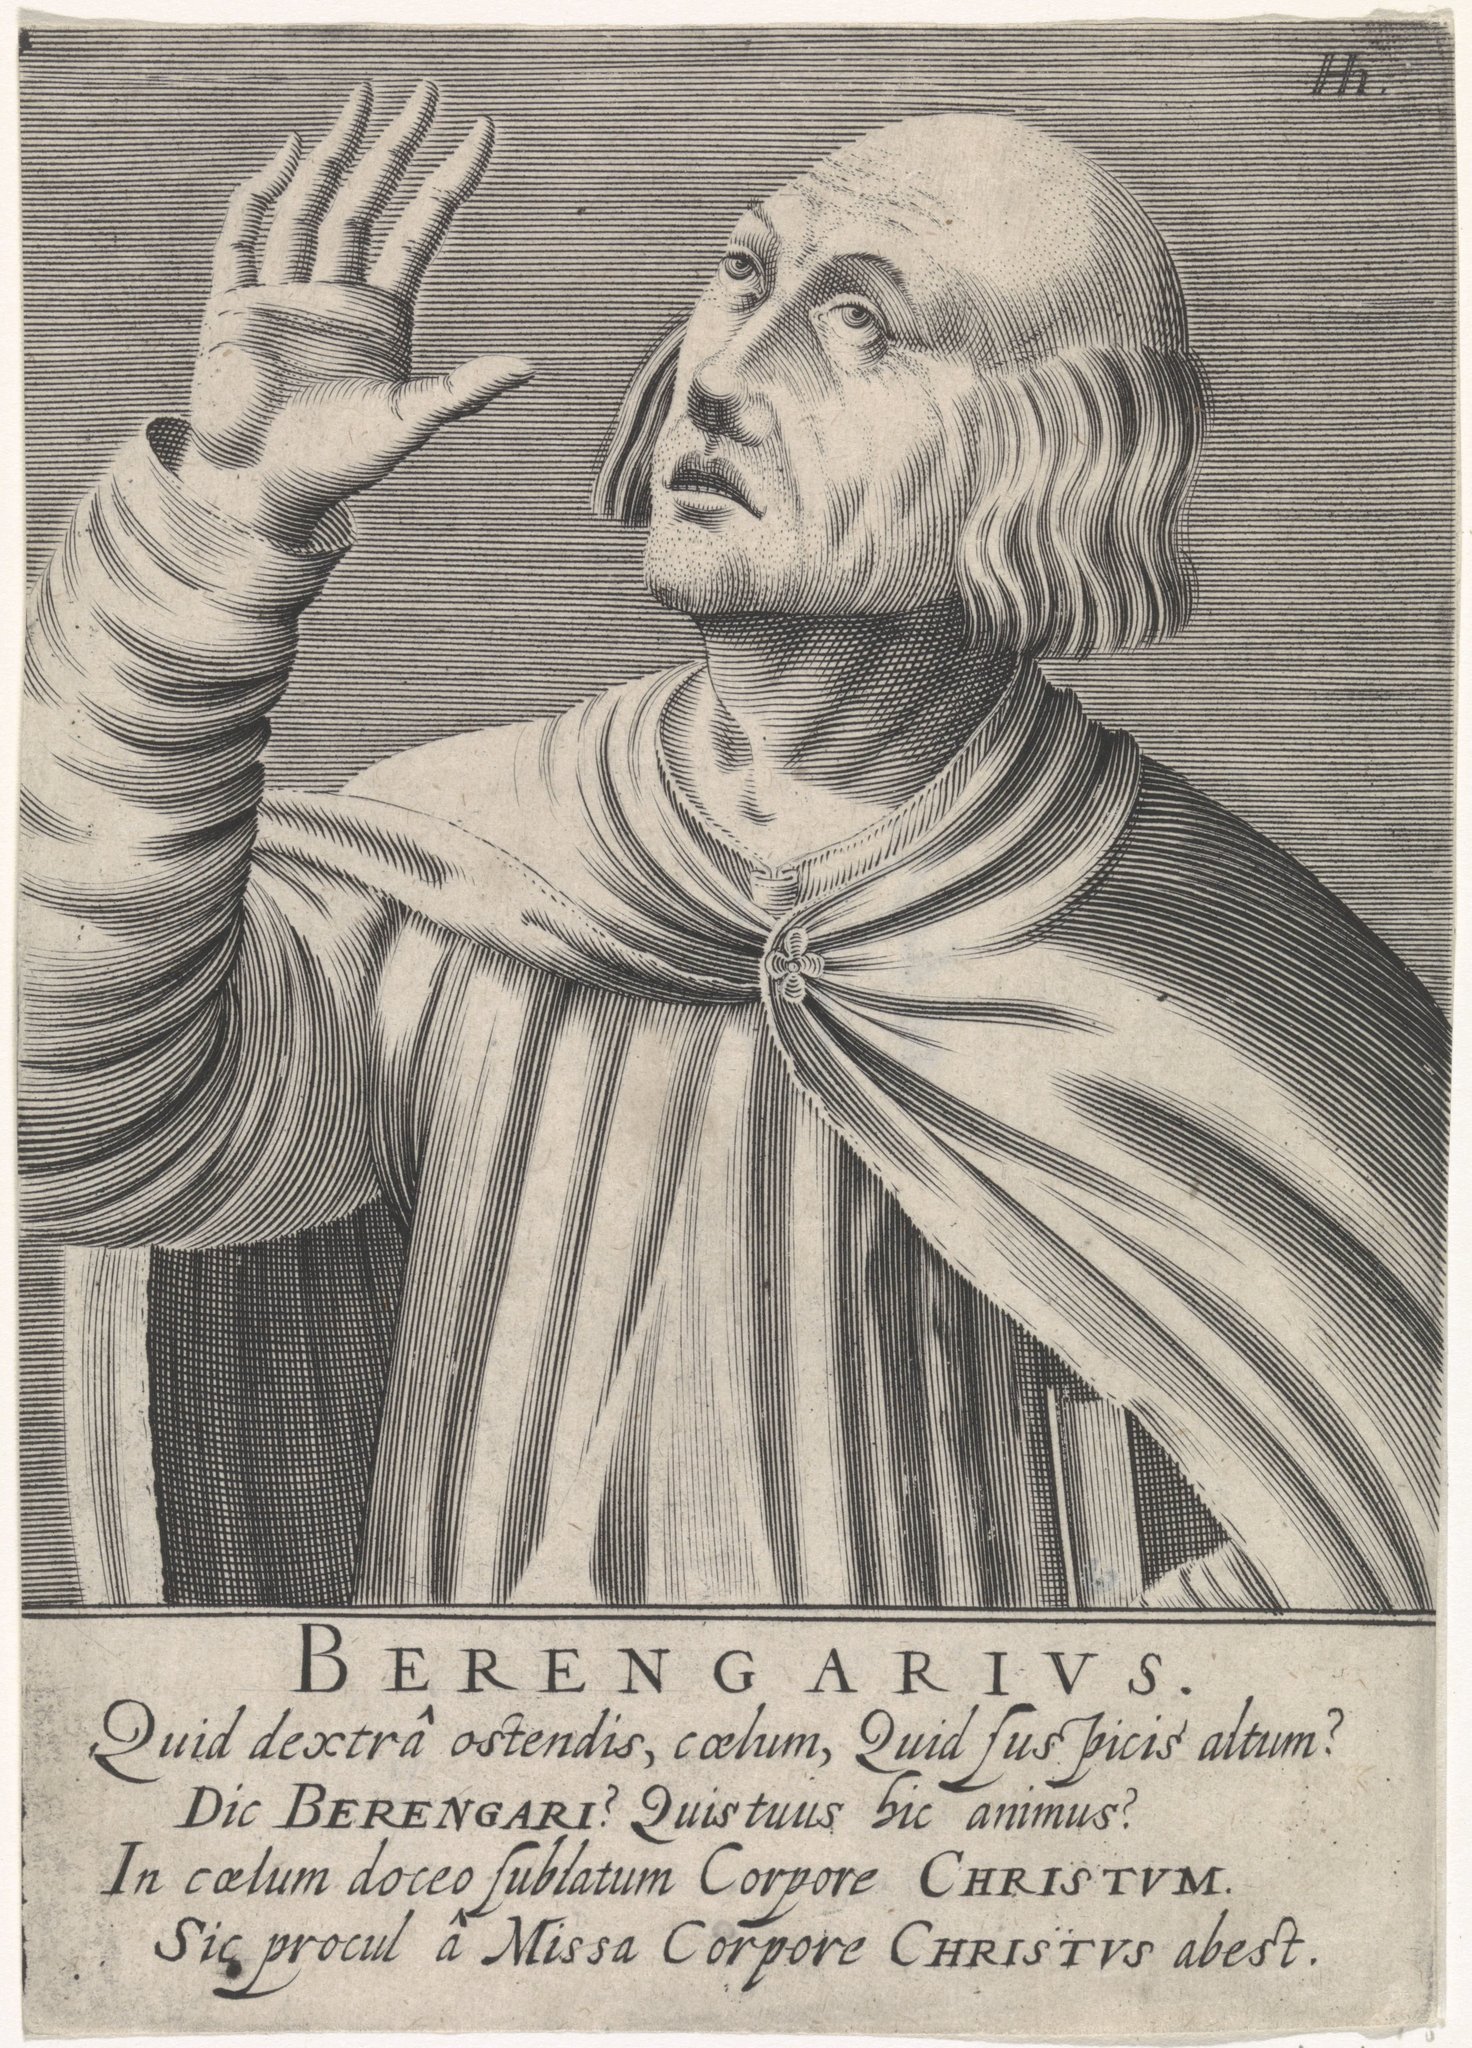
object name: print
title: Beroemde hervormers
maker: hendrick hondius (i)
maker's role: draughtsman, print maker, publisher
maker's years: 1573-1650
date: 1599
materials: paper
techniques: engraving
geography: the hague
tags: archdeacon of angers berenger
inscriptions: collector's mark: Lugt 2228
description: Prent ook gebruikt als boekillustratie in: Jacob Verheiden, Præstantium aliquot theologorum, qui rom. antichristum præcipuè oppugnarunt, effigies. Den Haag: Hendrick Hondius I en Den Haag: B.C. Nieulandt, 1602-1603. Tevens: Arnhem, J.Janssen, 1604.